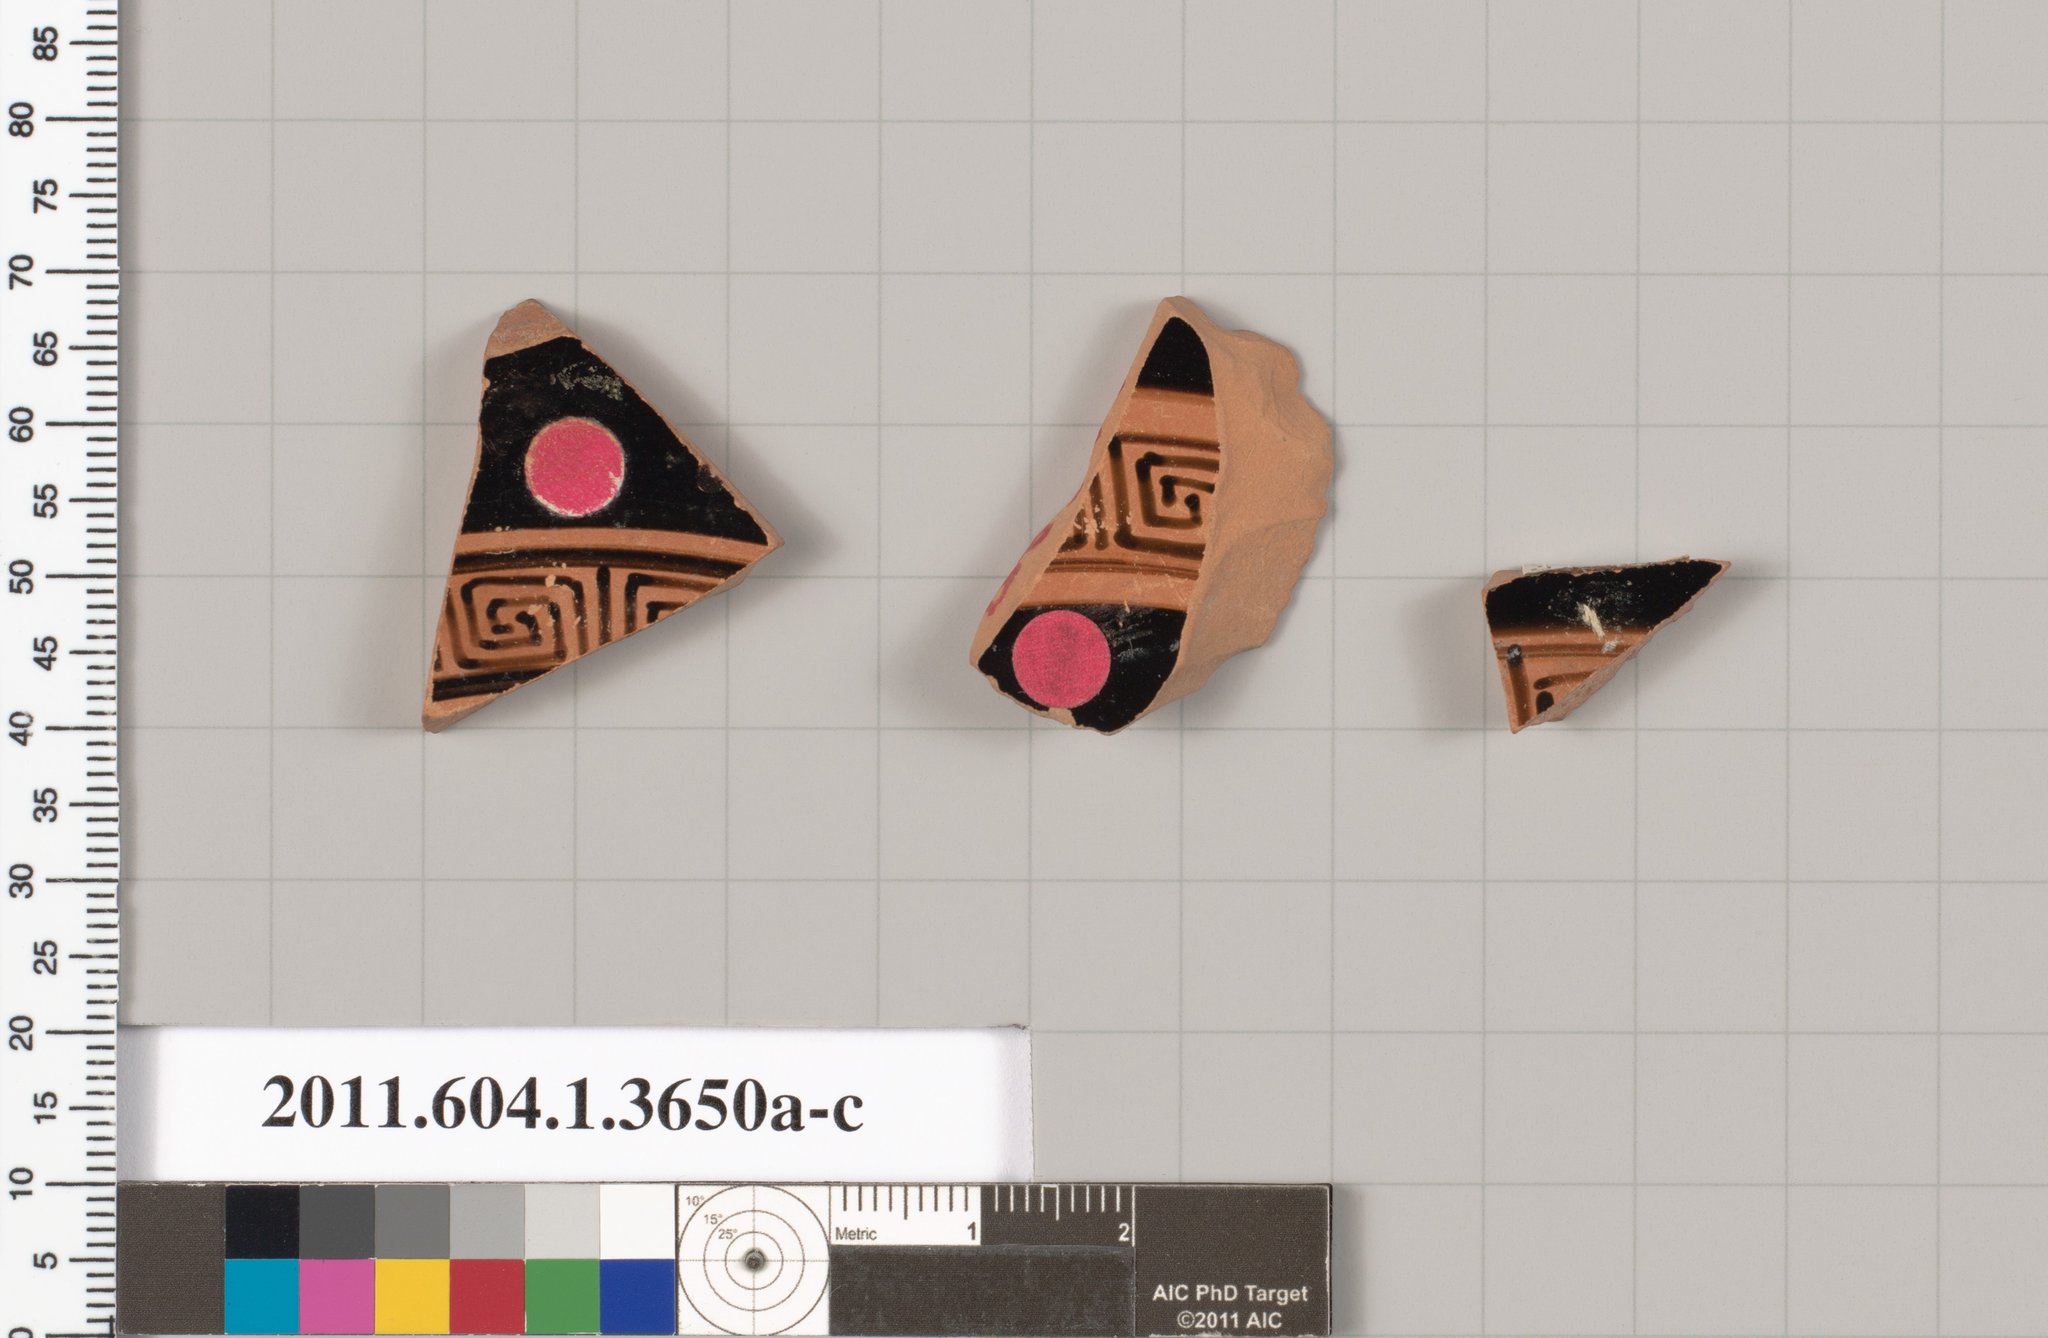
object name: kylix fragment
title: Terracotta fragments of kylikes (drinking cups)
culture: greek, attic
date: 500-470 BCE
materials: terracotta